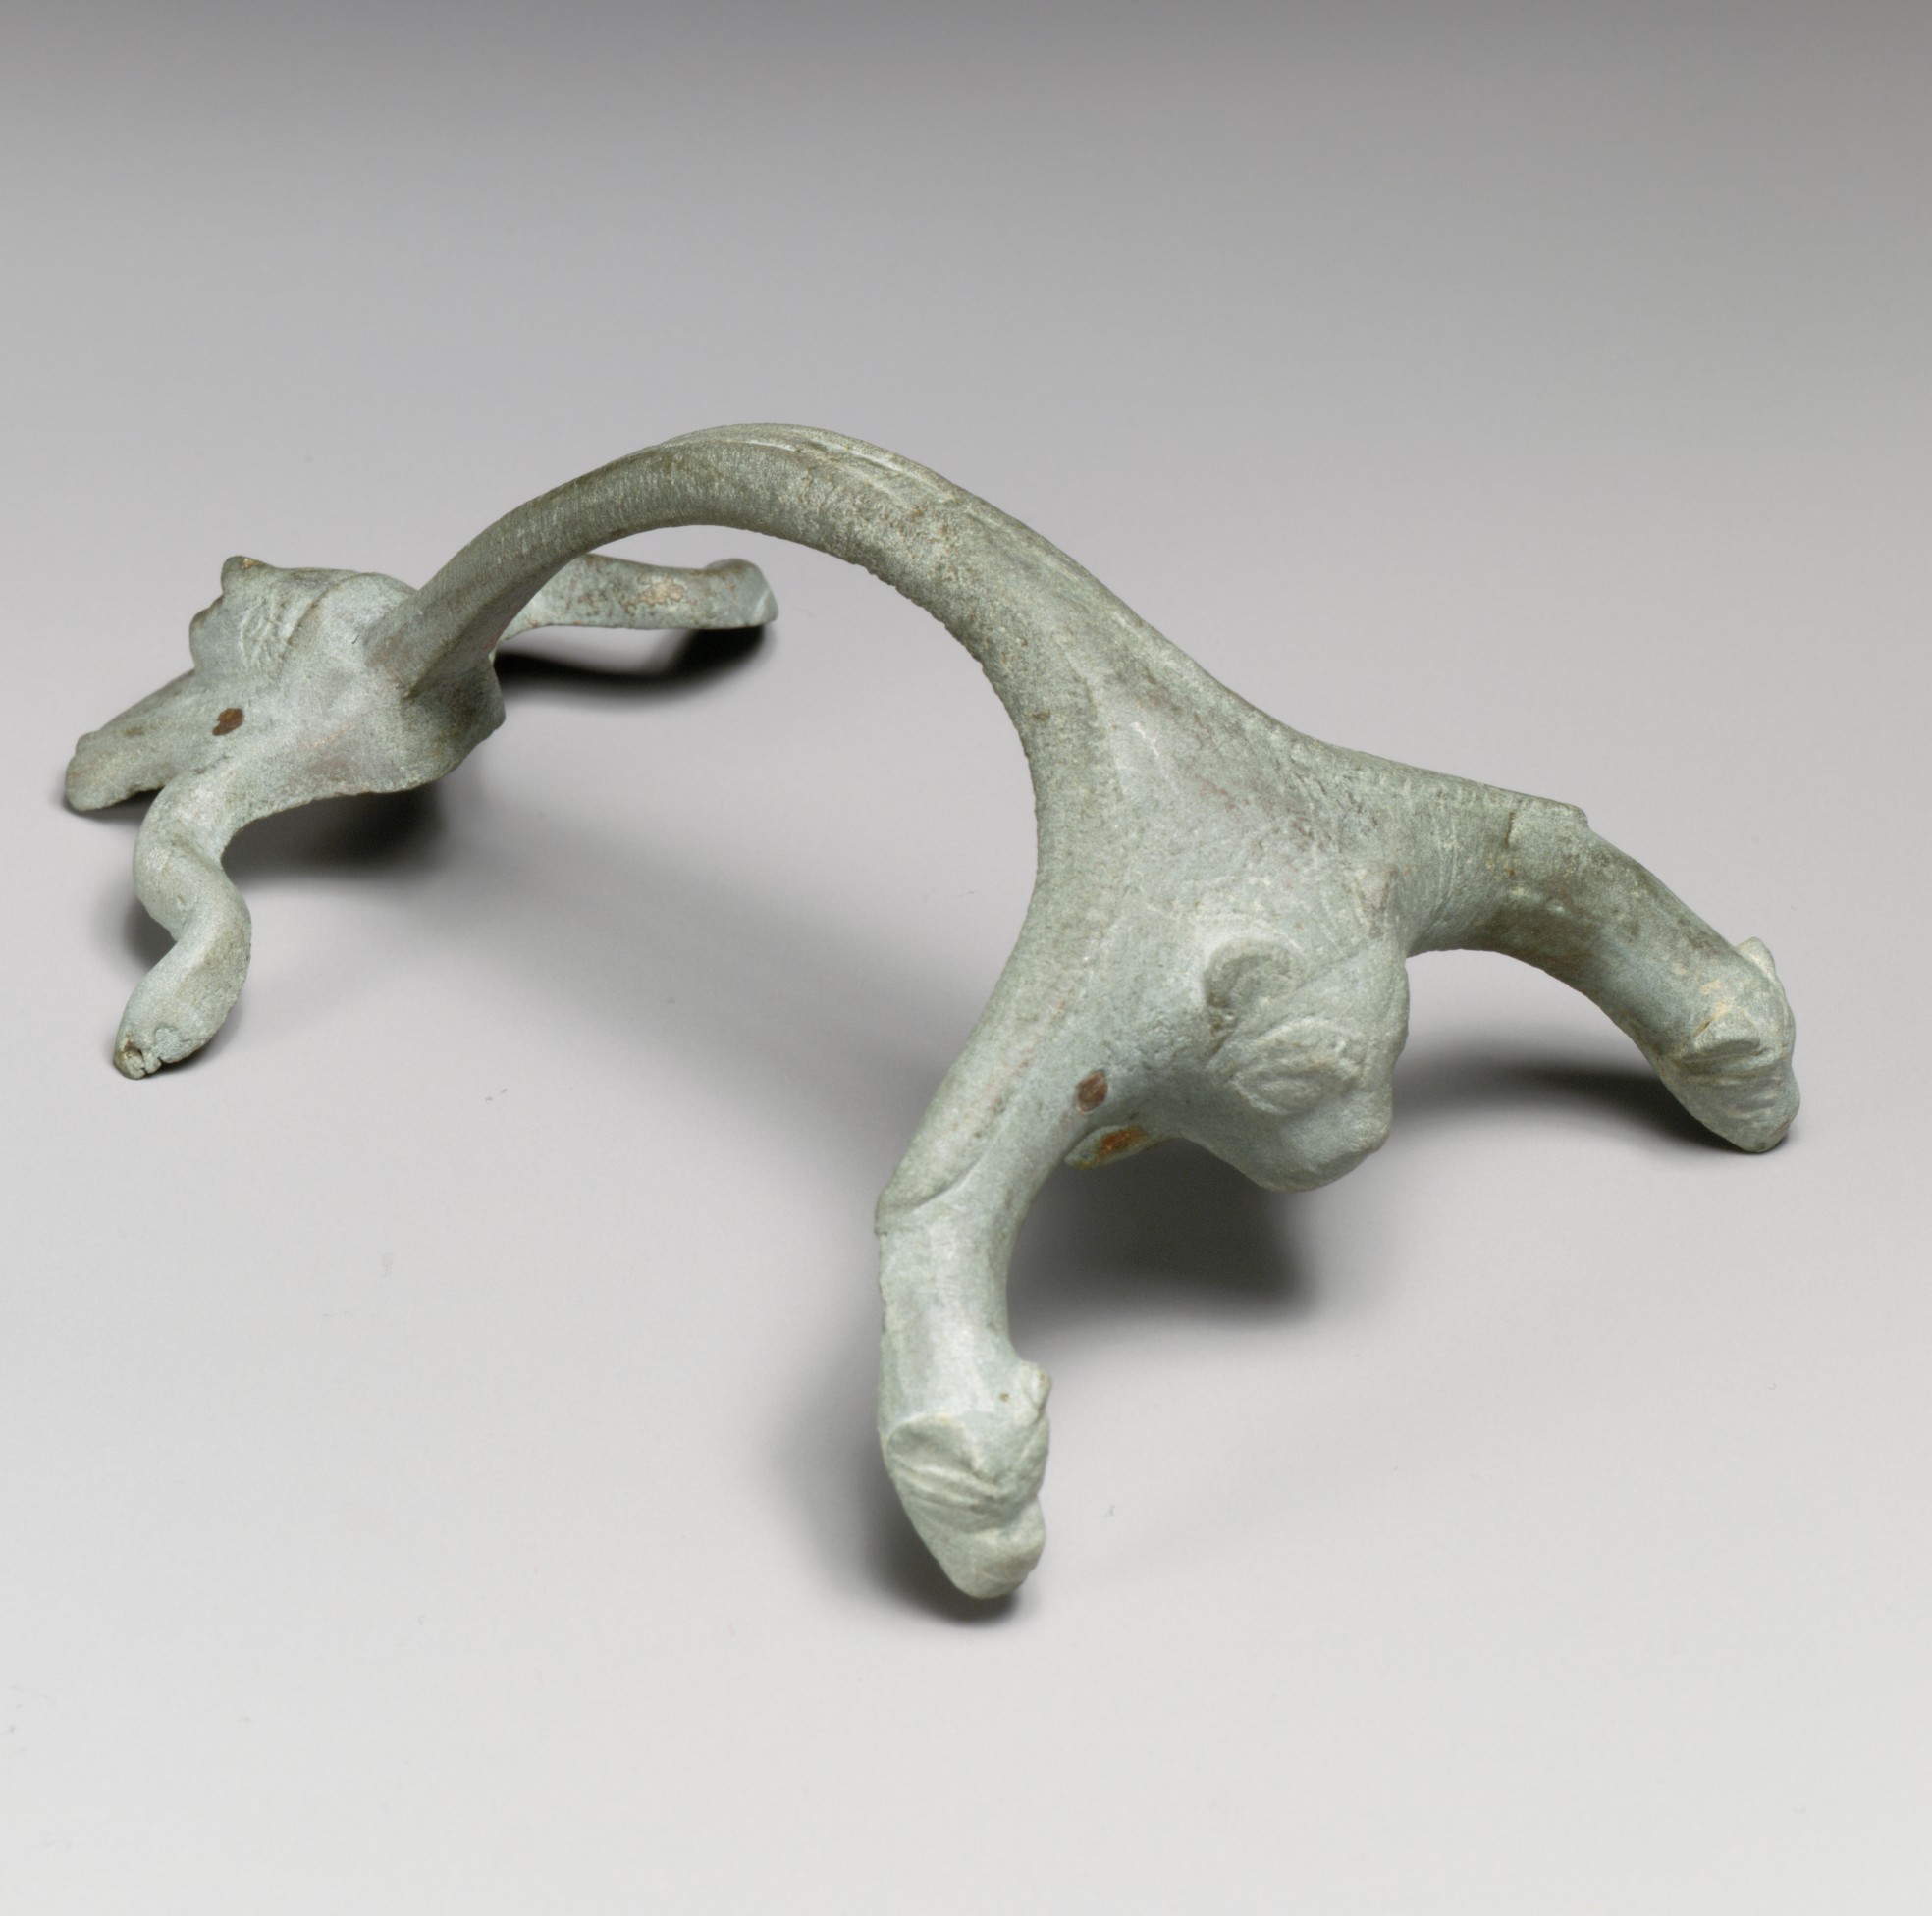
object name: handle of an oinochoe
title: Bronze oinochoe (jug) handle with lion's head and female protome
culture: etruscan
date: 500 BCE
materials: bronze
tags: women,lions